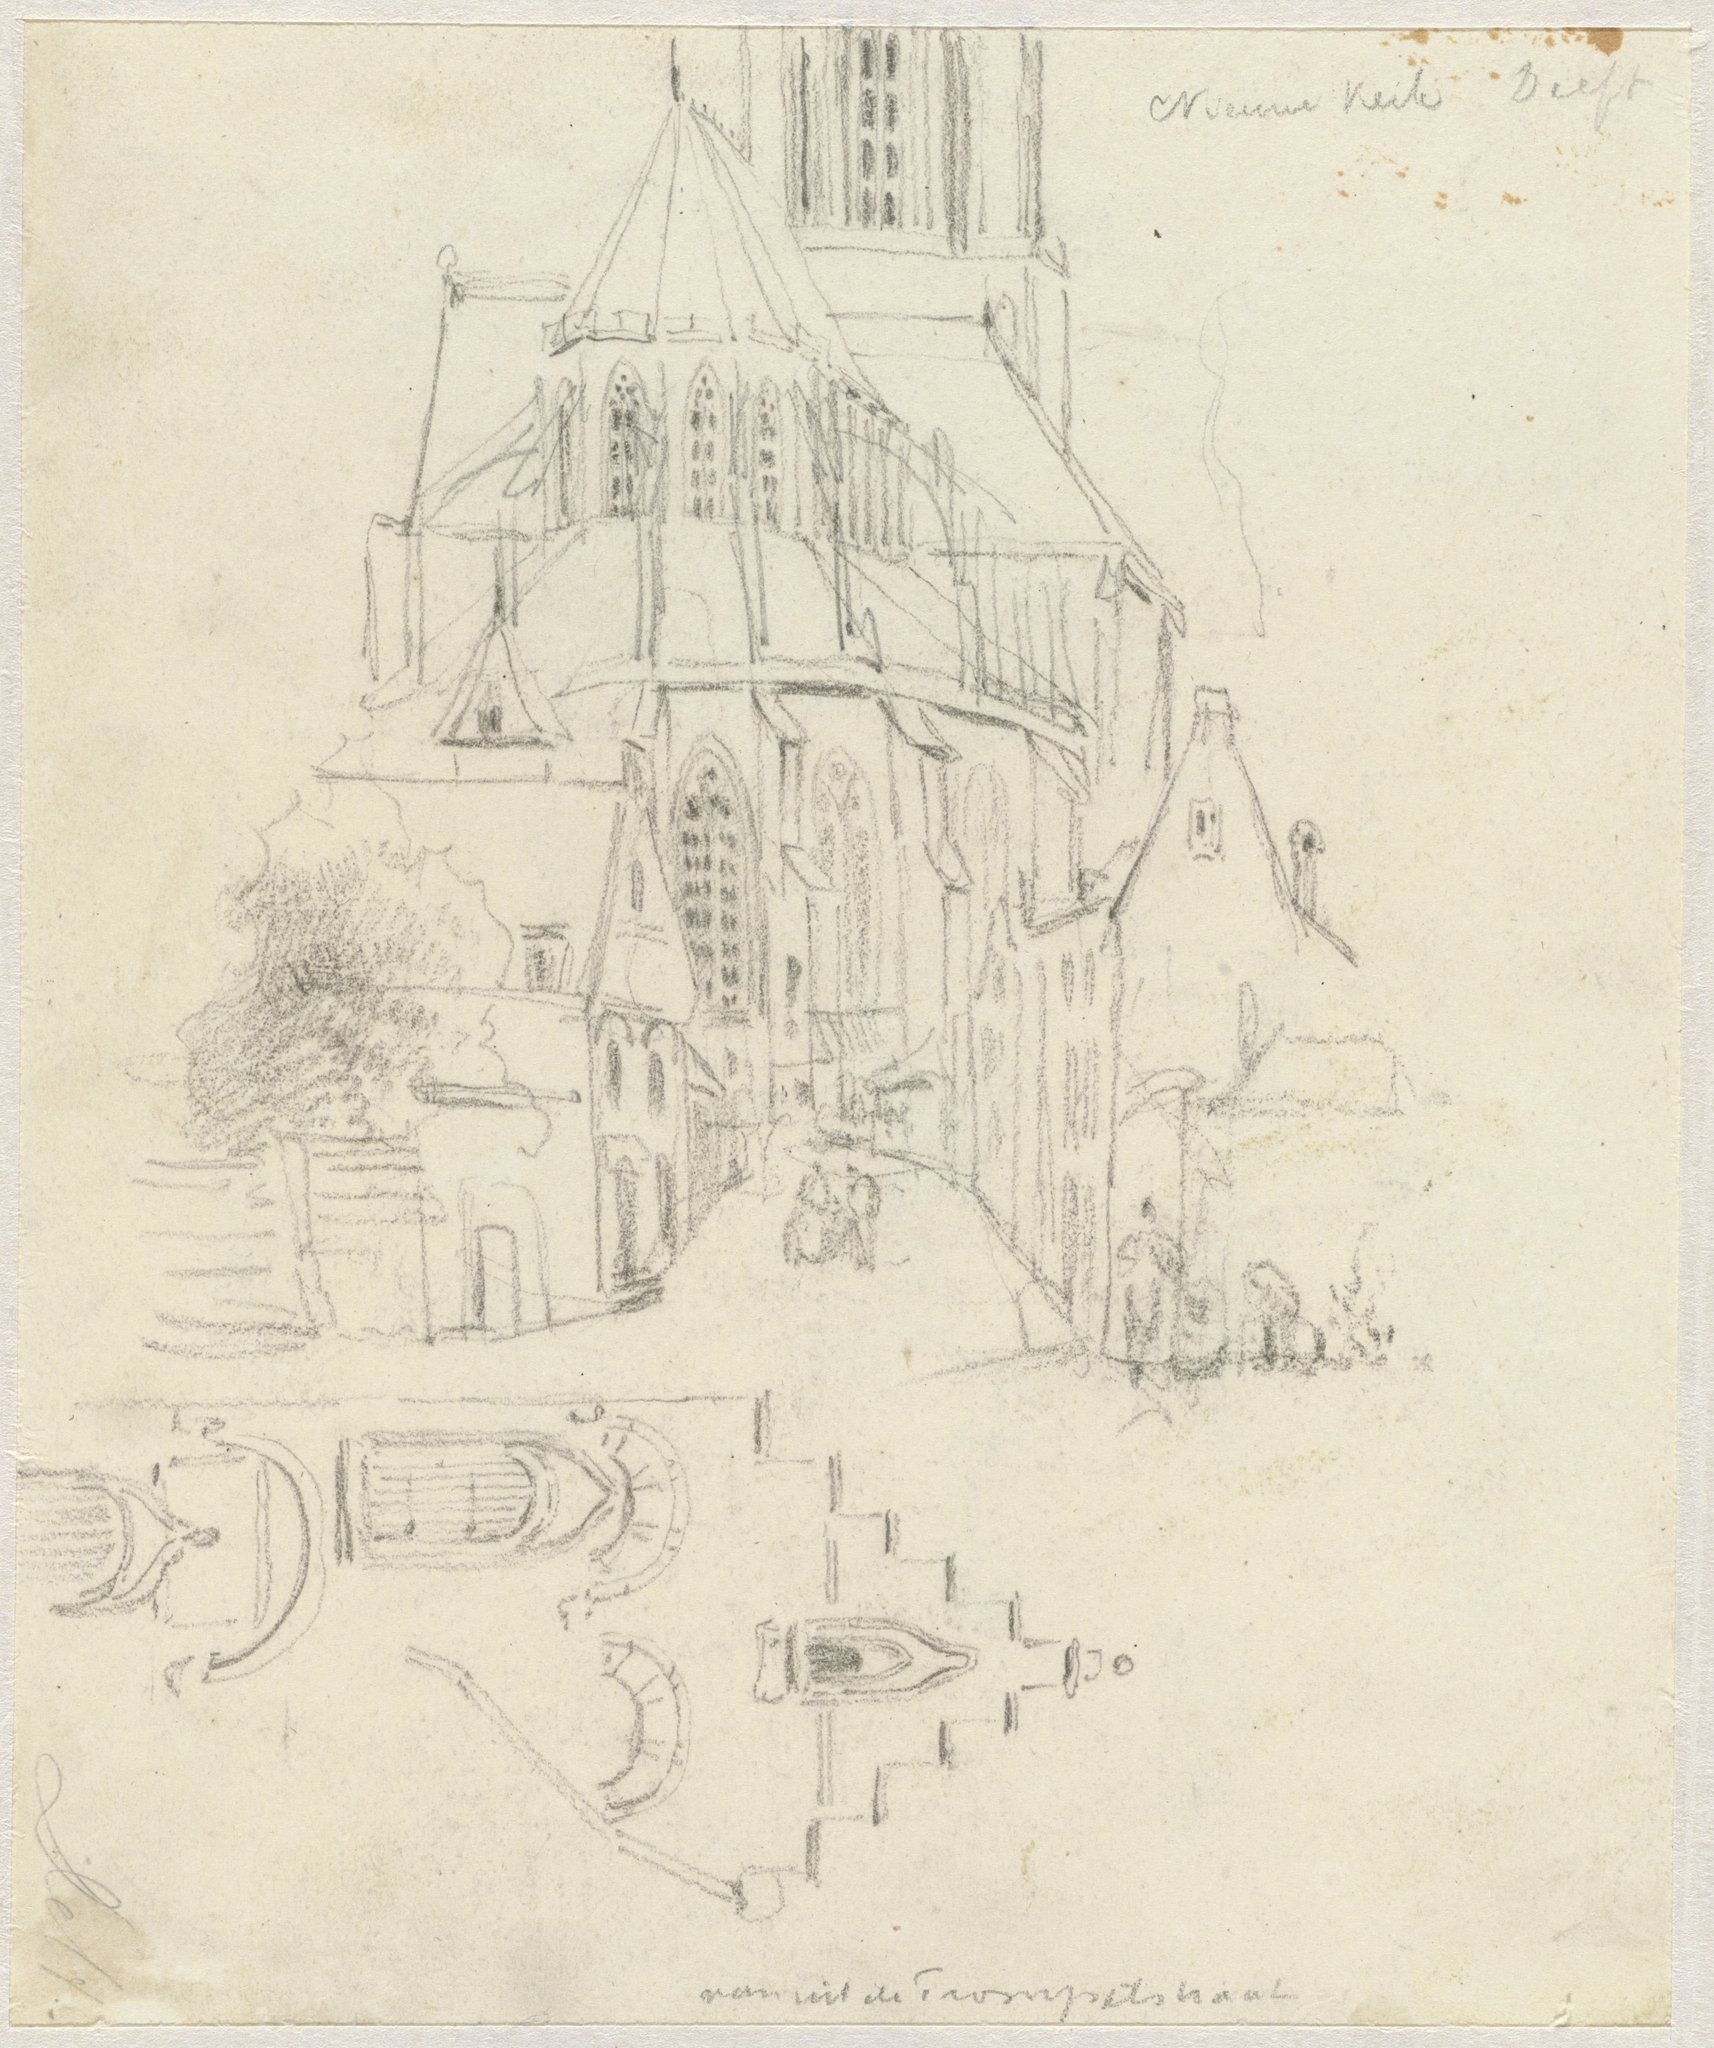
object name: drawing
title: Nieuwe Kerk en een trapgevel te Delft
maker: everhardus koster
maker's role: draughtsman, painter, print maker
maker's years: 1817-1892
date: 1827-1892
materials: chalk, paper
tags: church (exterior), delft